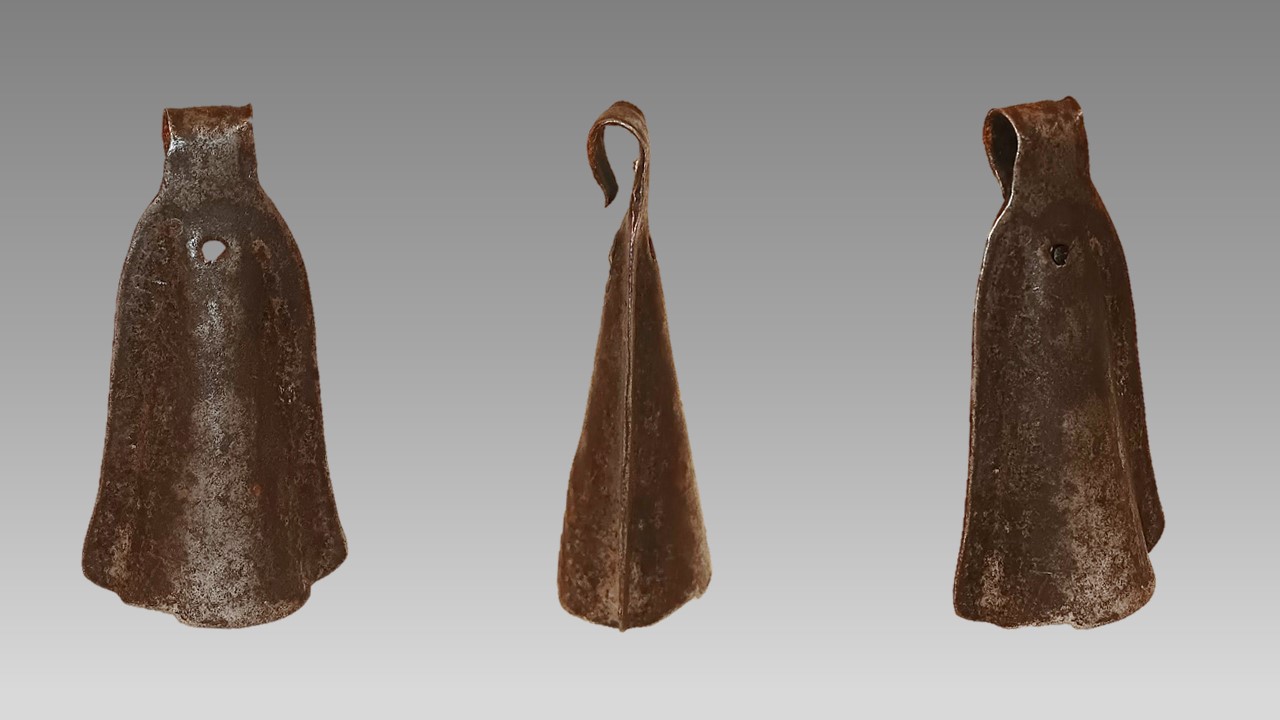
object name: ngonge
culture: african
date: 1800-1889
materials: metal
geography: west coast